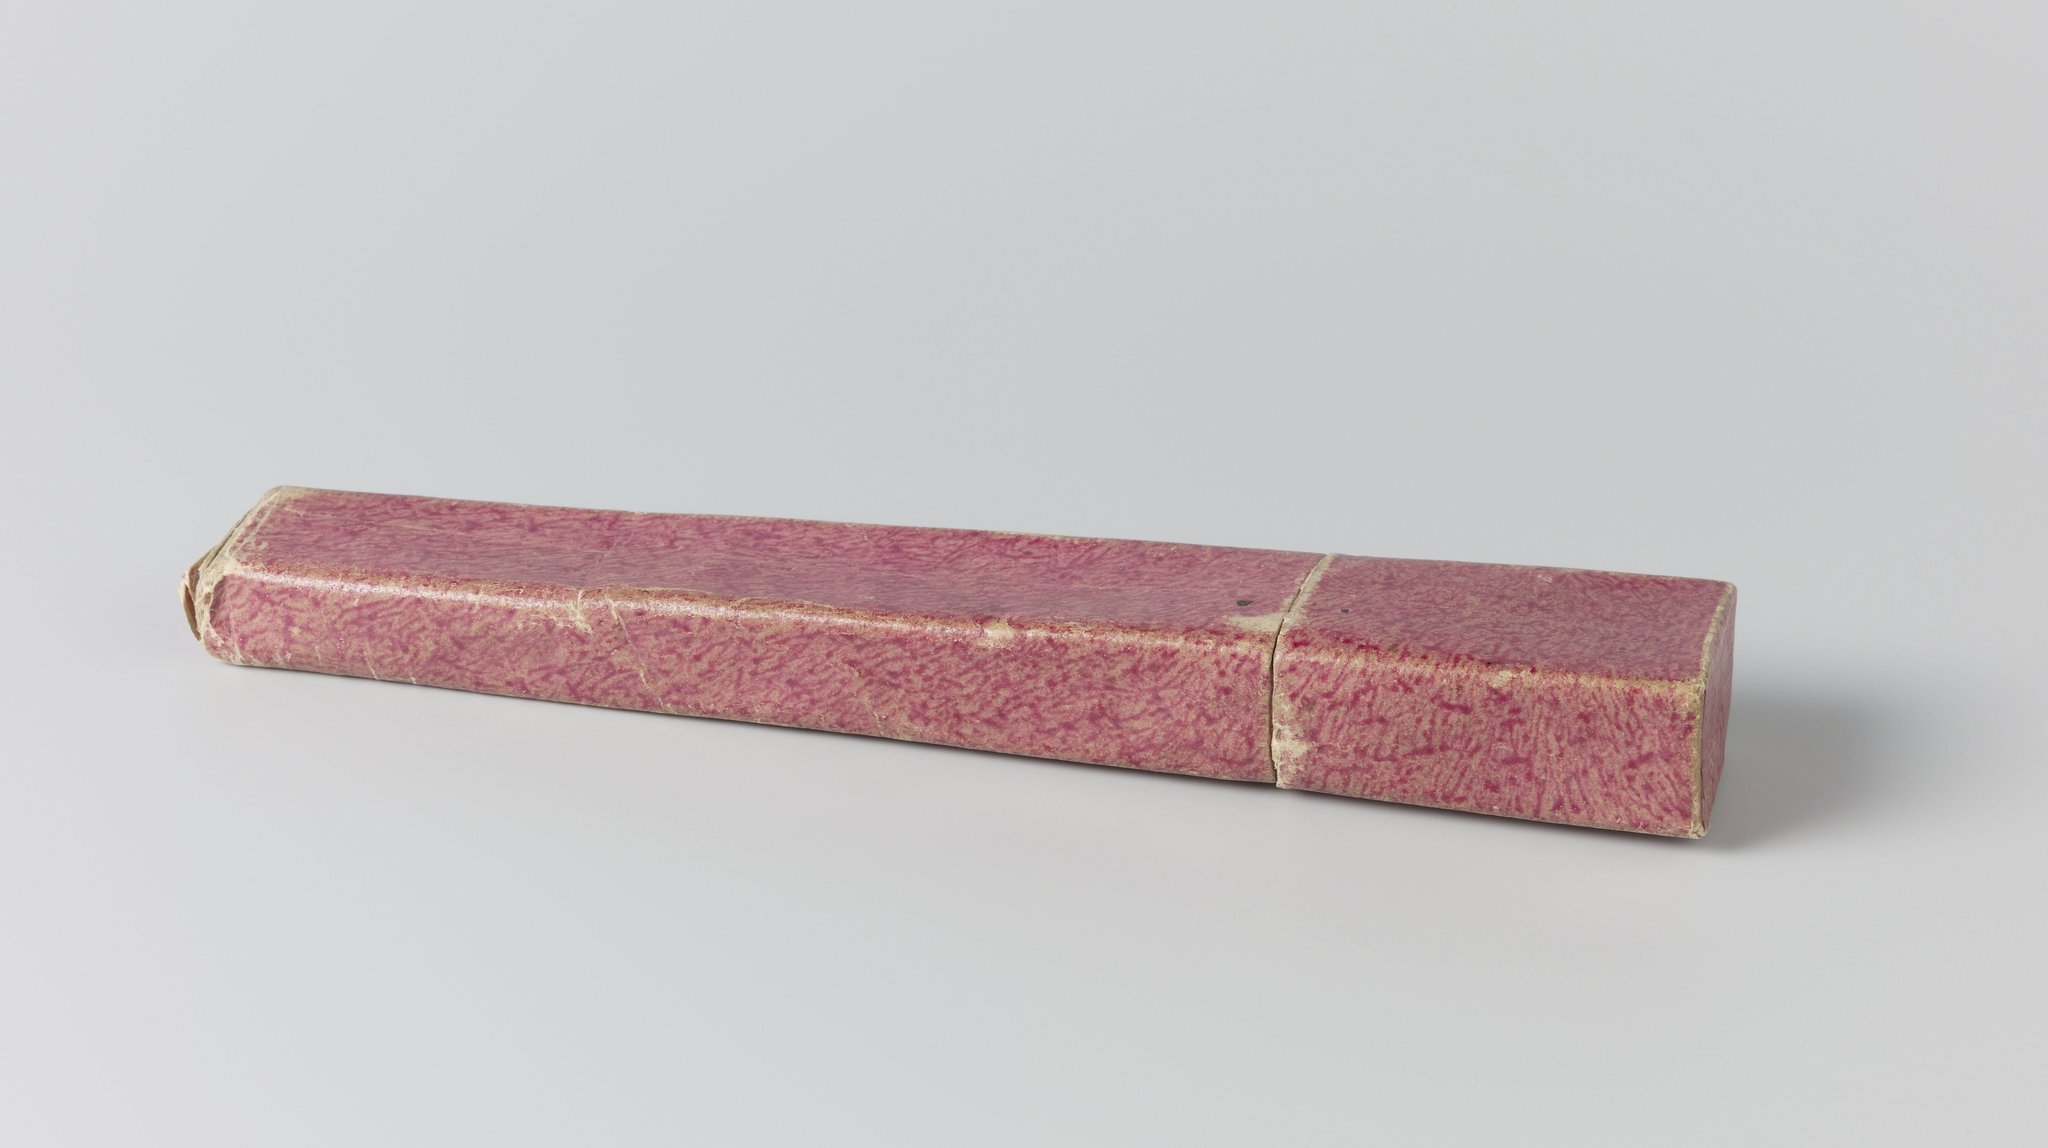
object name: waaierdoos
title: Foedraal van karton voor waaier, bekleed met rood stijfselmarmer en gevoerd met Frans krantenpapier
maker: Anonymous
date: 1700-1800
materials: cardboard, paper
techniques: marbling, printing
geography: netherlands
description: Foedraal van karton voor waaier, bestaande uit schacht en deksel aan de buitenkant bekleed met rood stijfselmarmer. Hals van de schacht beplakt met blauw stijfsel marmer papier. Gevoerd met Frans krantenpapier.